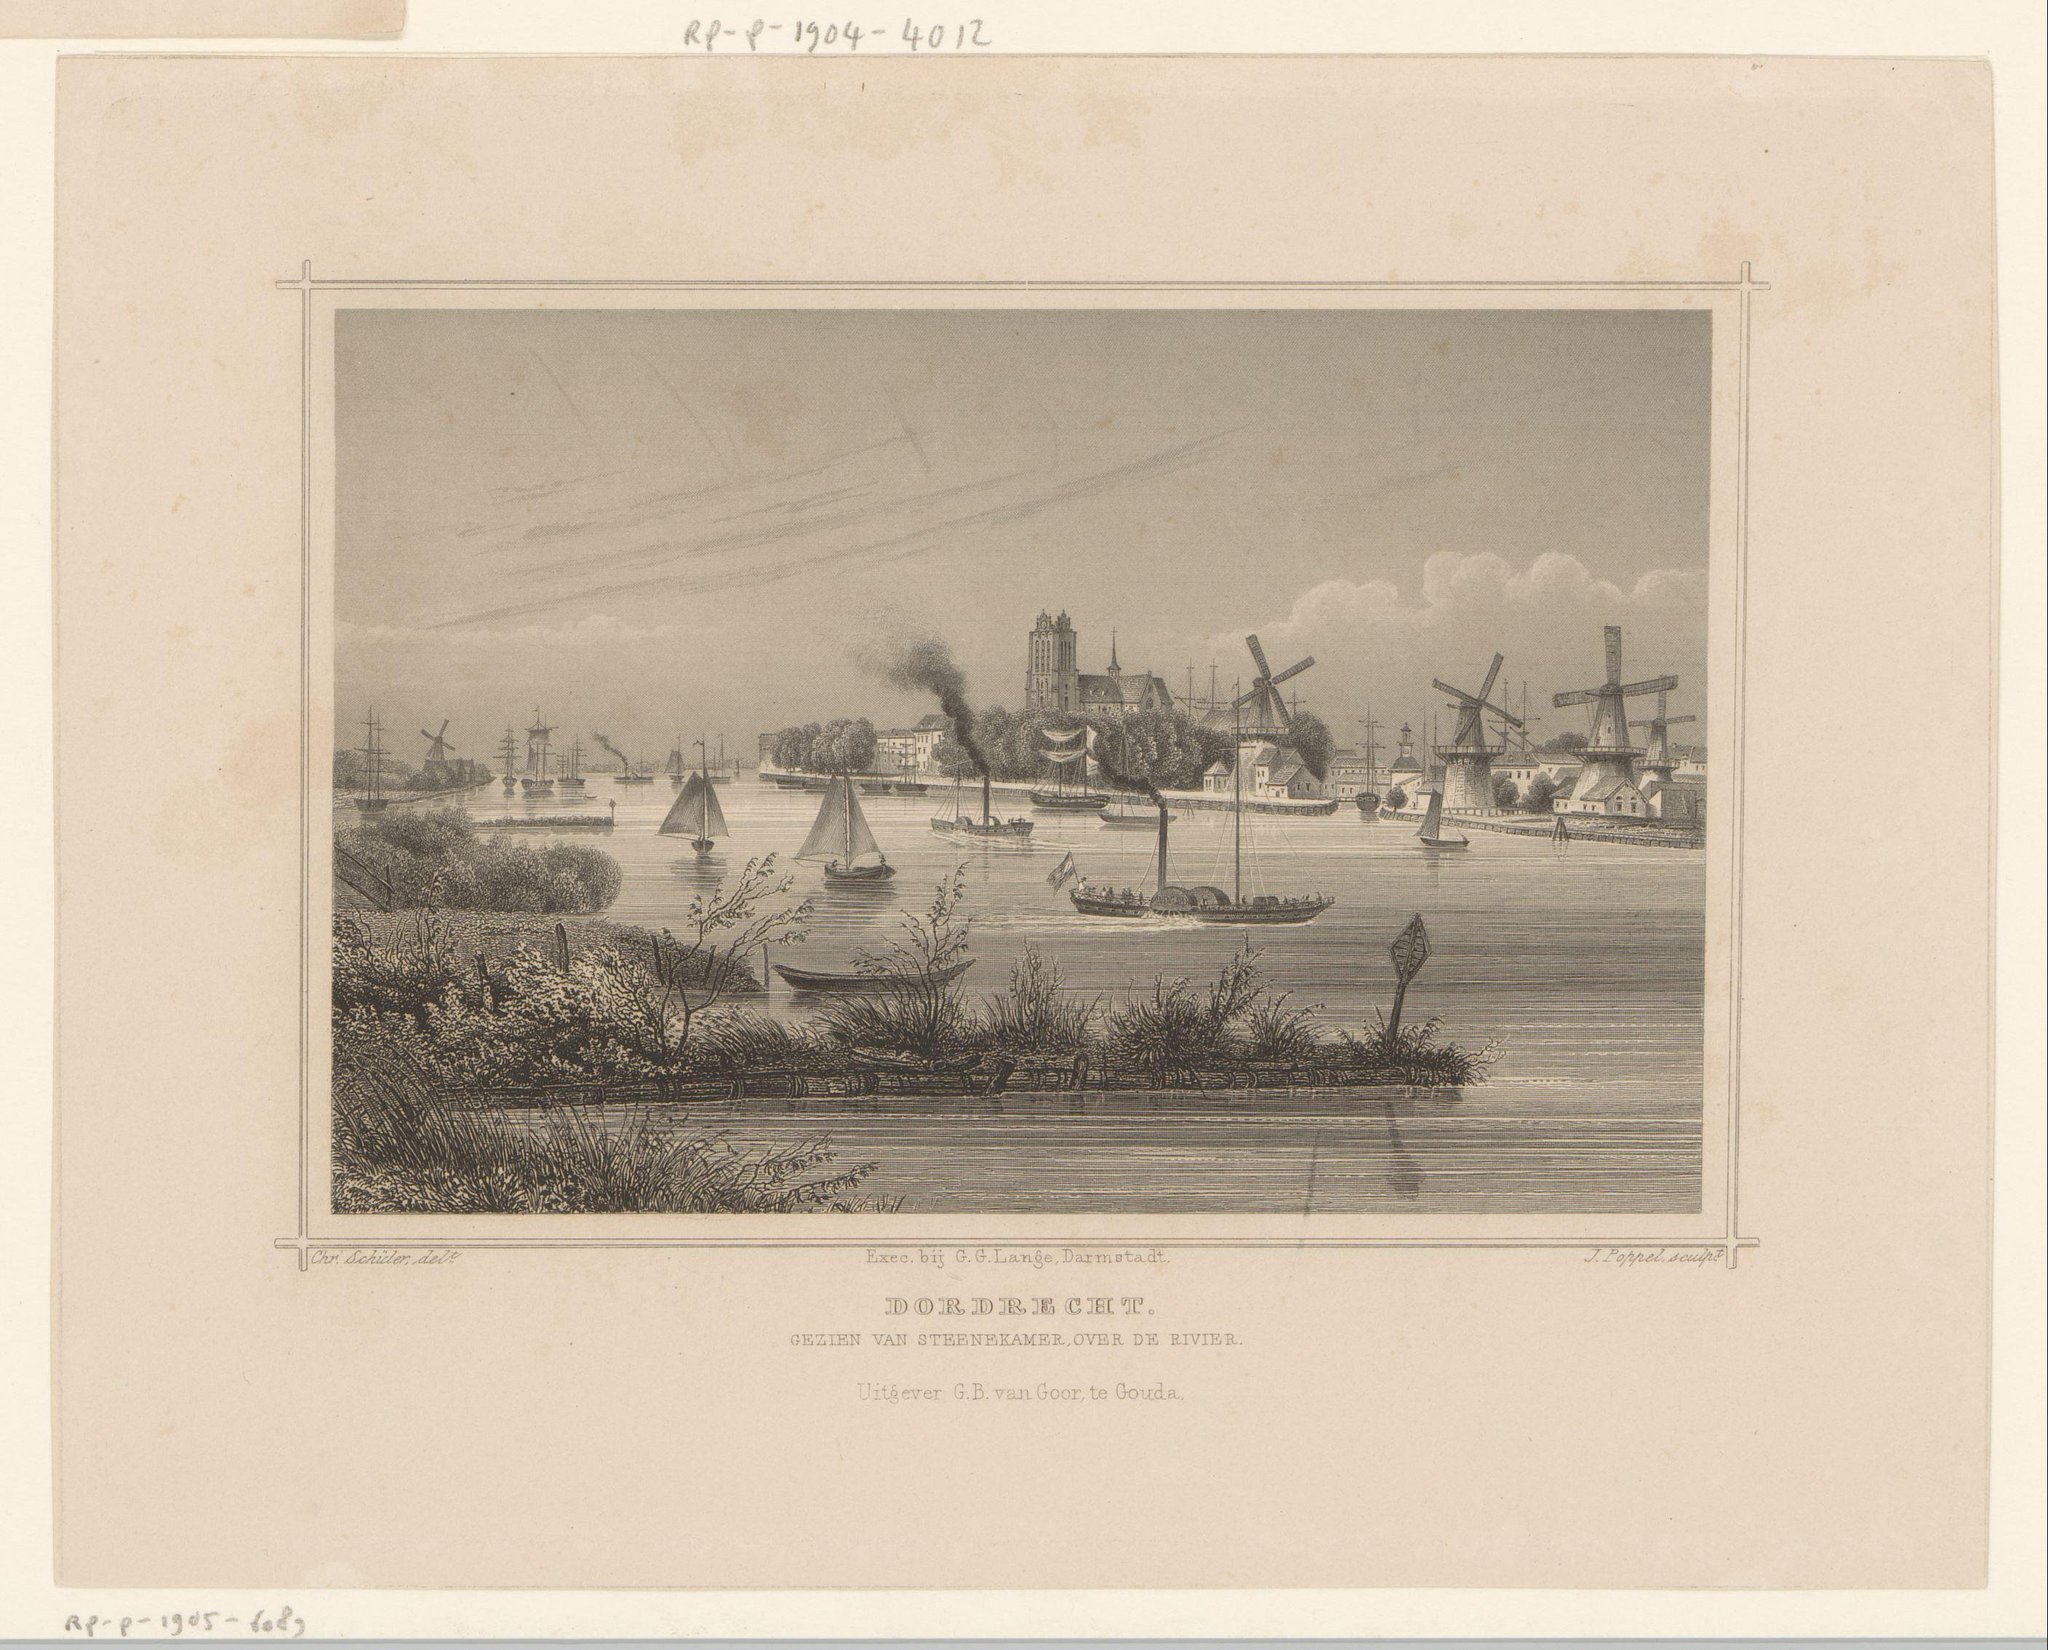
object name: print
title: Gezicht op Dordrecht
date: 1858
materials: paper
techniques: engraving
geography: darmstadt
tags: city-view, and landscape with man-made constructions, windmill in landscape, ships (in general) - cc - more than one ship, dordrecht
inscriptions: collector's mark: Lugt 2228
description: Prent ook gebruikt in: Terwen, Johannes Leonardus. Het Koningrijk der Nederlanden voorgesteld in eene reeks van naar de natuur geteekende schilderachtige gezigten. Gouda: Van Goor, 1858-1862.